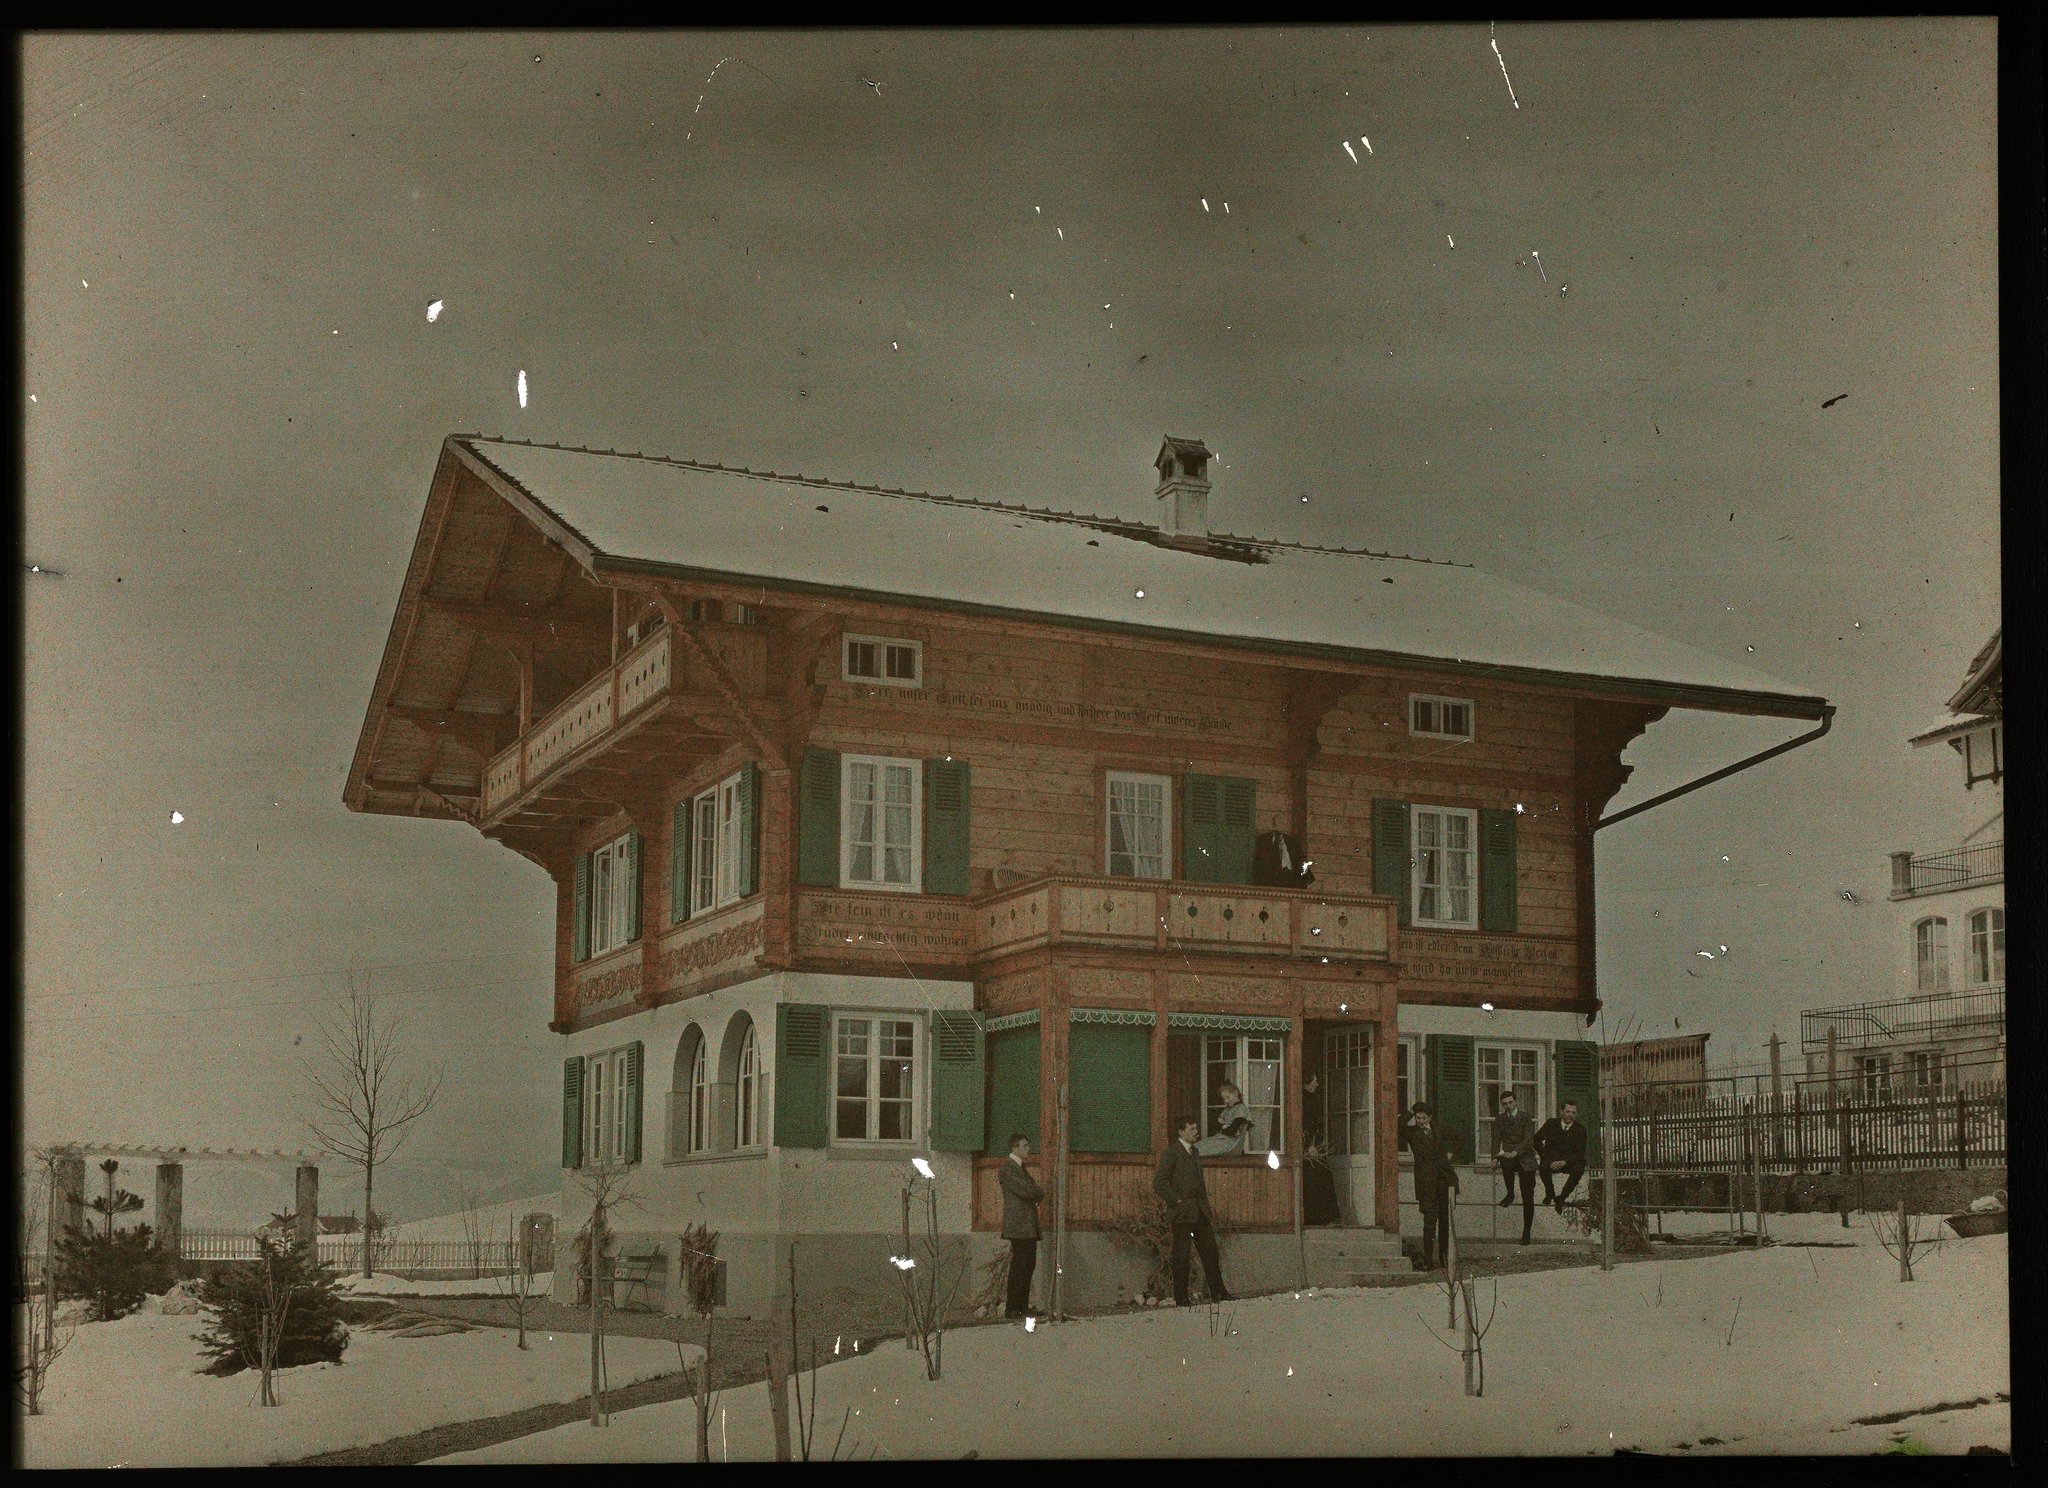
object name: color slide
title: Een chalet in de sneeuw, met zes figuren ervoor (of in de vensterbank)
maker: adolphe burdet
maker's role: fotograaf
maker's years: 1860-1940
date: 1907-1930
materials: glass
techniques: autochrome process, slide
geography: switzerland